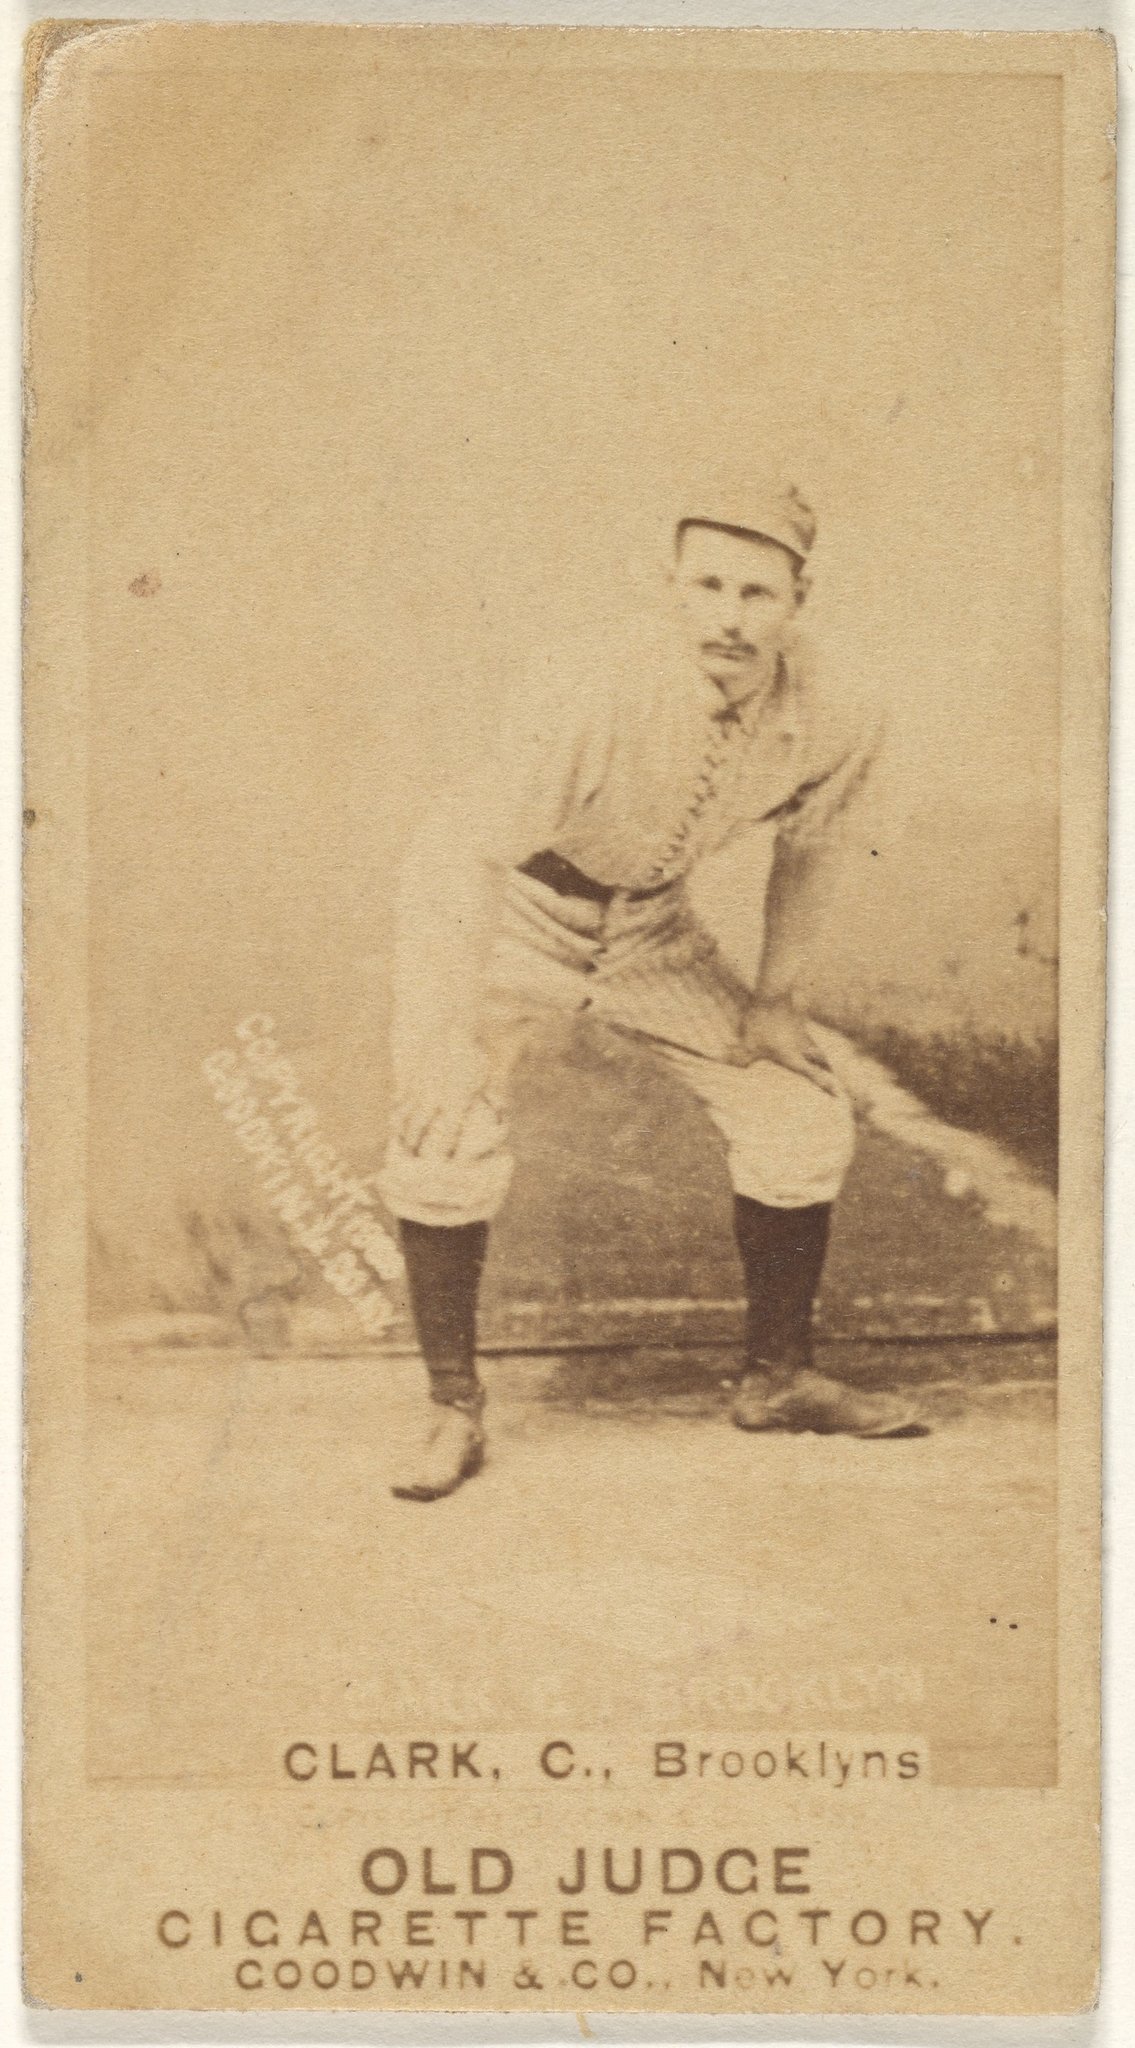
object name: baseball card, photograph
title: Clark, Catcher, Brooklyn, from the Old Judge series (N172) for Old Judge Cigarettes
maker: goodwin & company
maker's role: publisher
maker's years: 1850-1950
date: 1887-1890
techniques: albumen silver print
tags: men,portraits,baseball,athletes